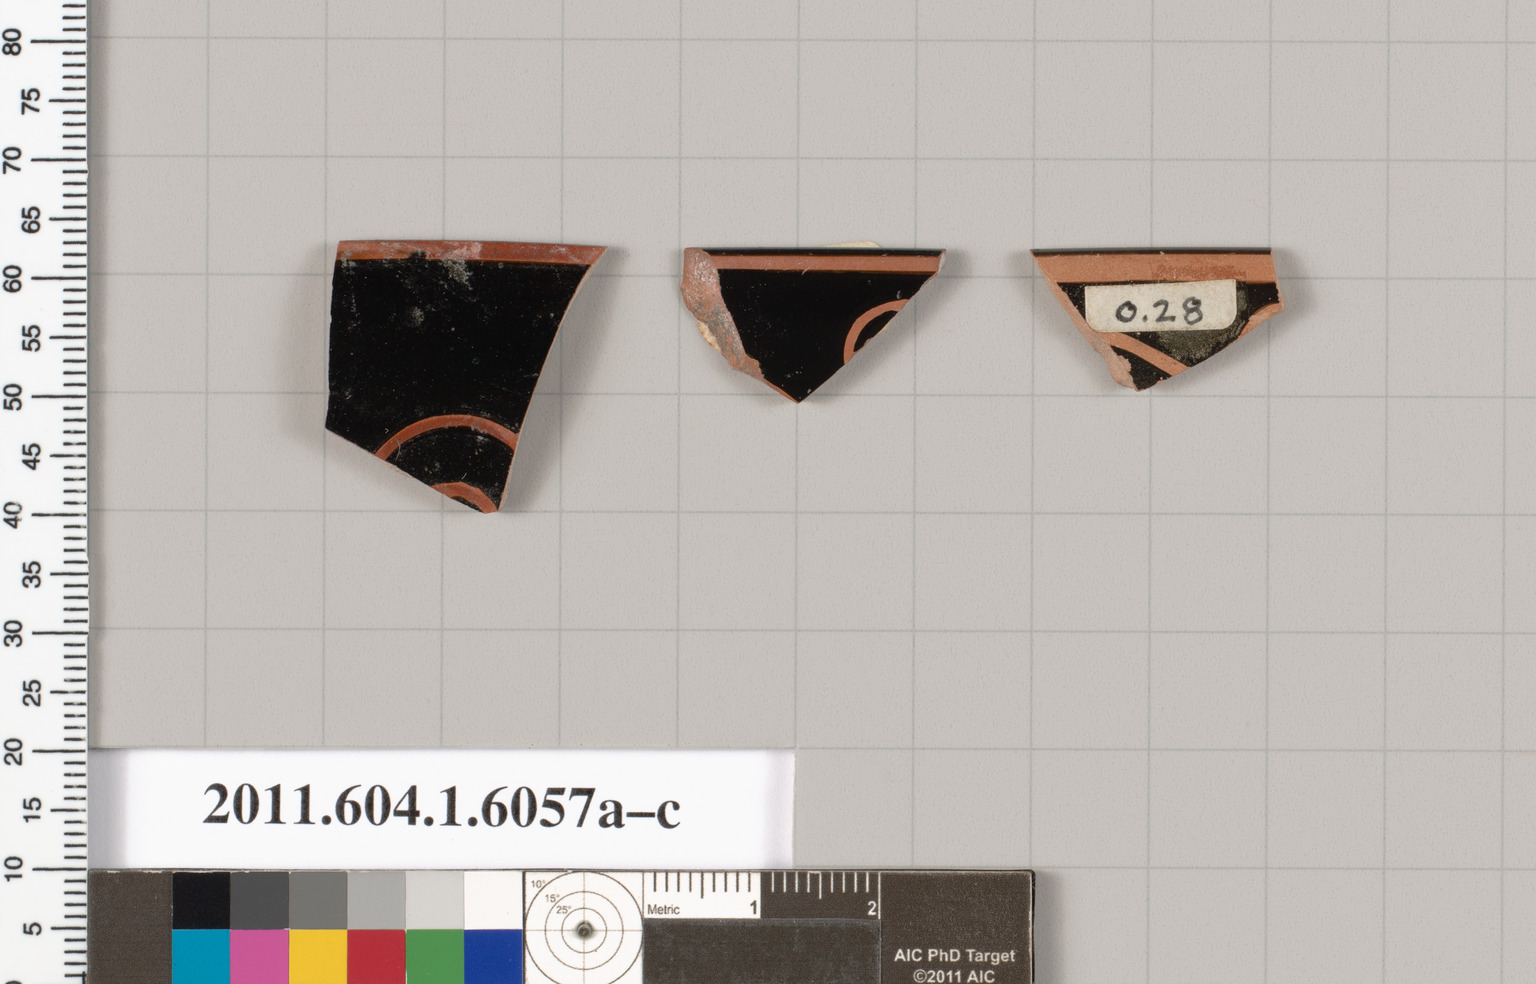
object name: kylix fragment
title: Terracotta rim fragments of kylikes (drinking cups)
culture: greek, attic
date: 510-500 BCE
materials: terracotta